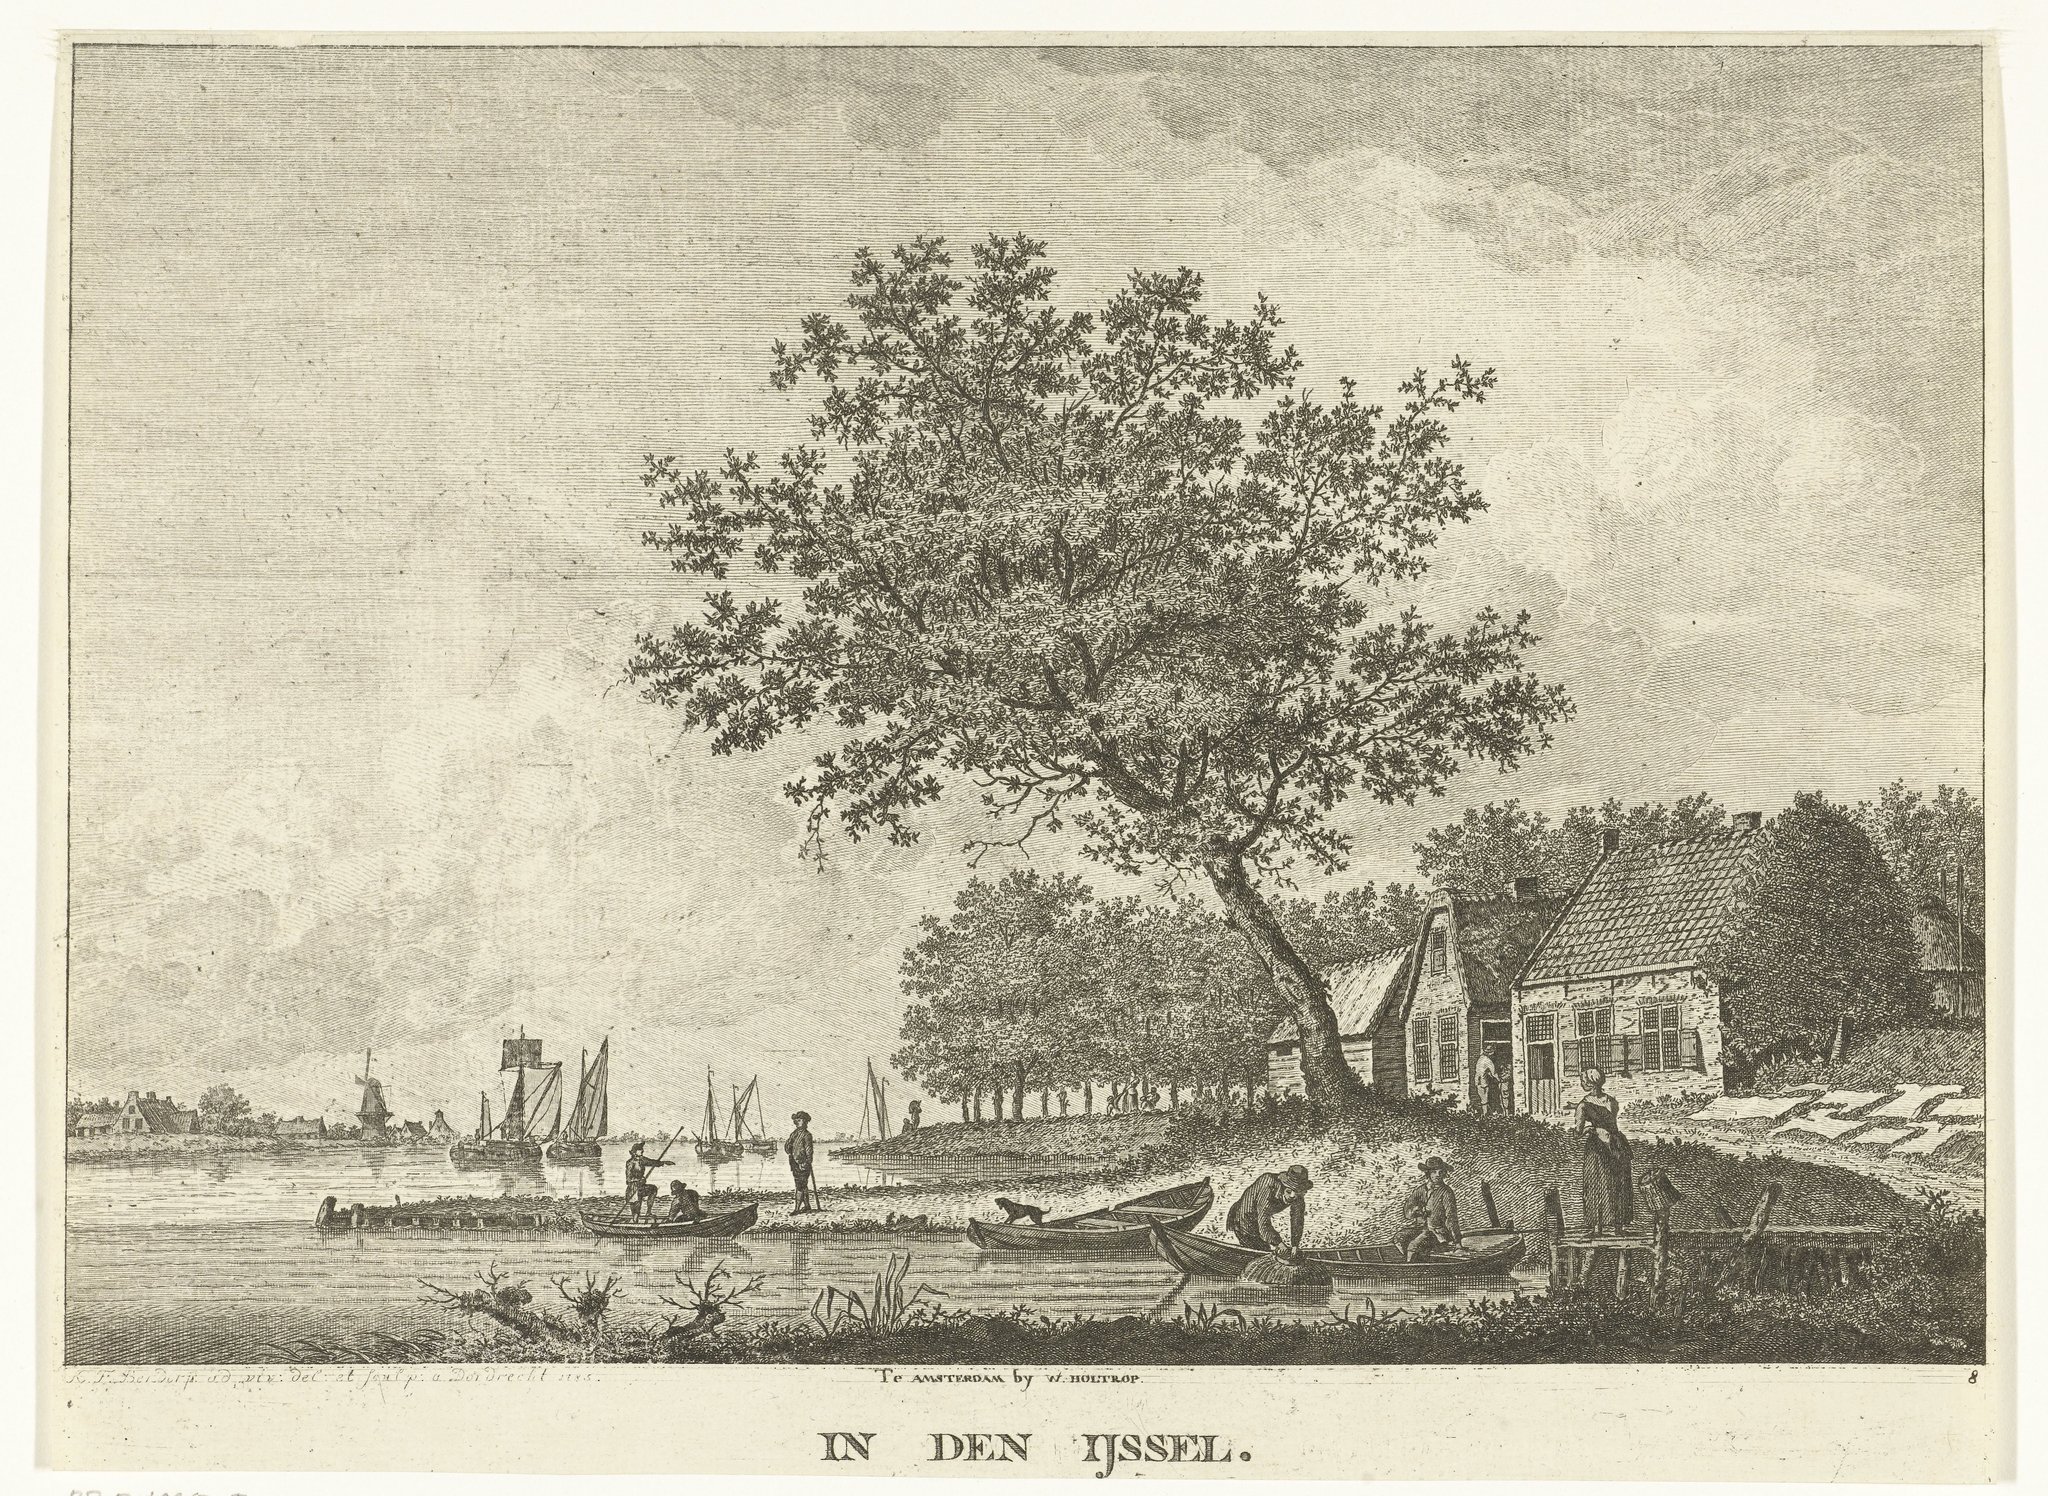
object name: print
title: Riviergezicht vanaf oever IJssel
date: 1785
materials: paper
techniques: etching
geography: amsterdam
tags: river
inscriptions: collector's mark: Lugt 2228